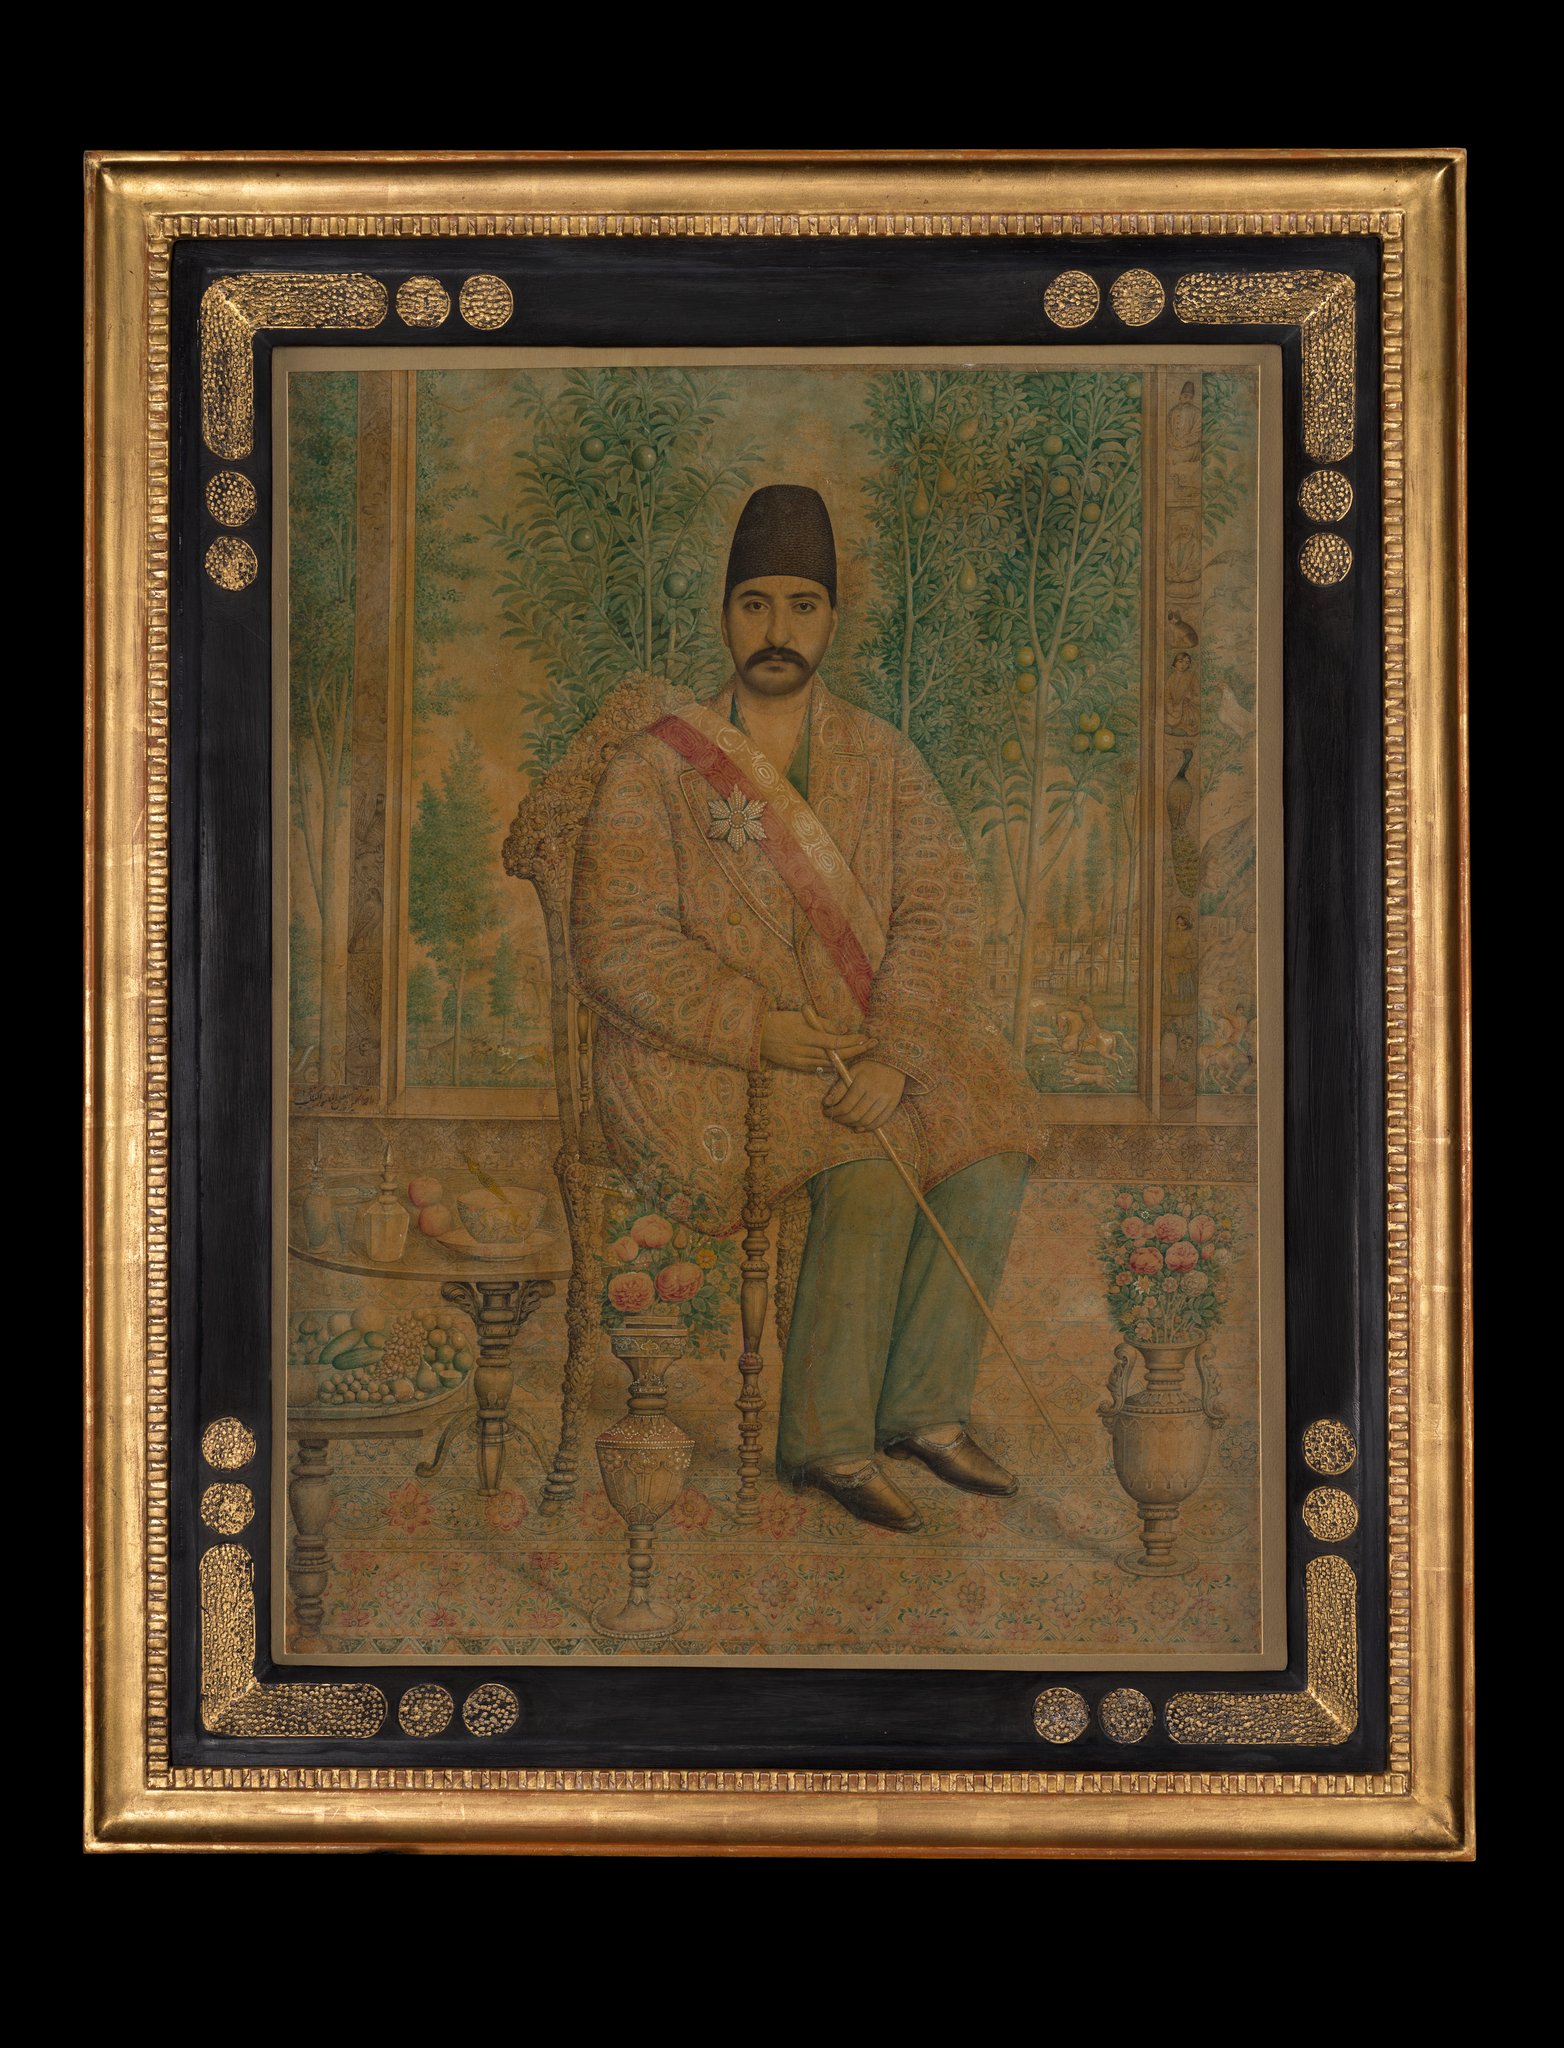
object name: illustrated single work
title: Portrait of Mirza 'Ali Asghar Khan (Amin al-Mulk, Amin al-Sultan, Atabeg-i Azam)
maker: isma'il jalayir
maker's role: artist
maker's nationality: iranian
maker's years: 1785-1899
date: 1880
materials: paper, watercolor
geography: iran